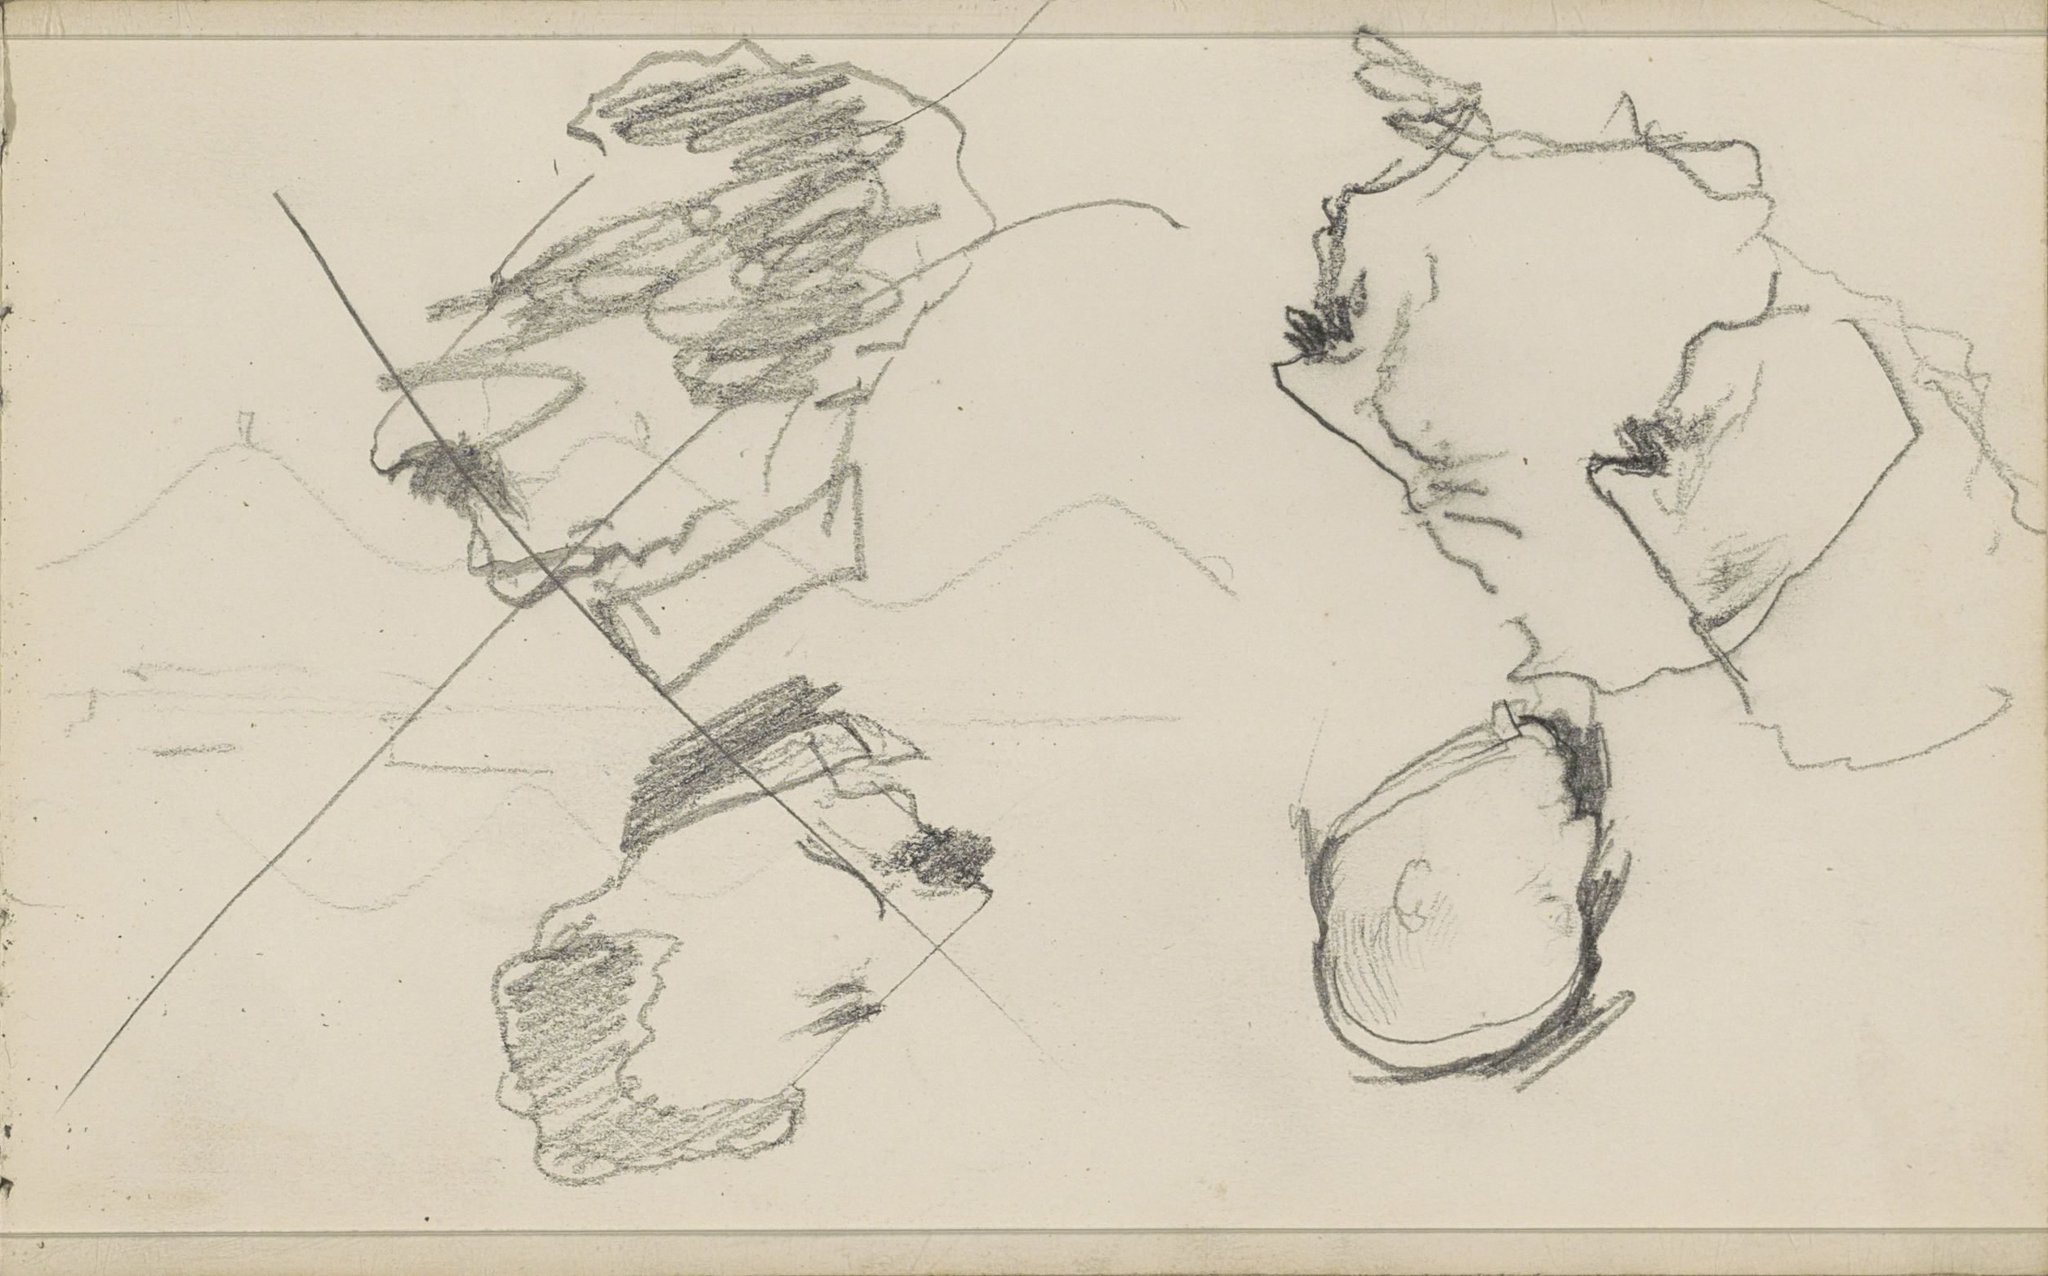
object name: sketchbook leaf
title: Vier mannenkoppen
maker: anton mauve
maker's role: draughtsman, painter, print maker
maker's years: 1838-1888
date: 1848-1888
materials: paper, pencil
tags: head (human) (+ male human being (not to be used where -a- is prescribed))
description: Blad 40 recto uit een schetsboek met 42 bladen.